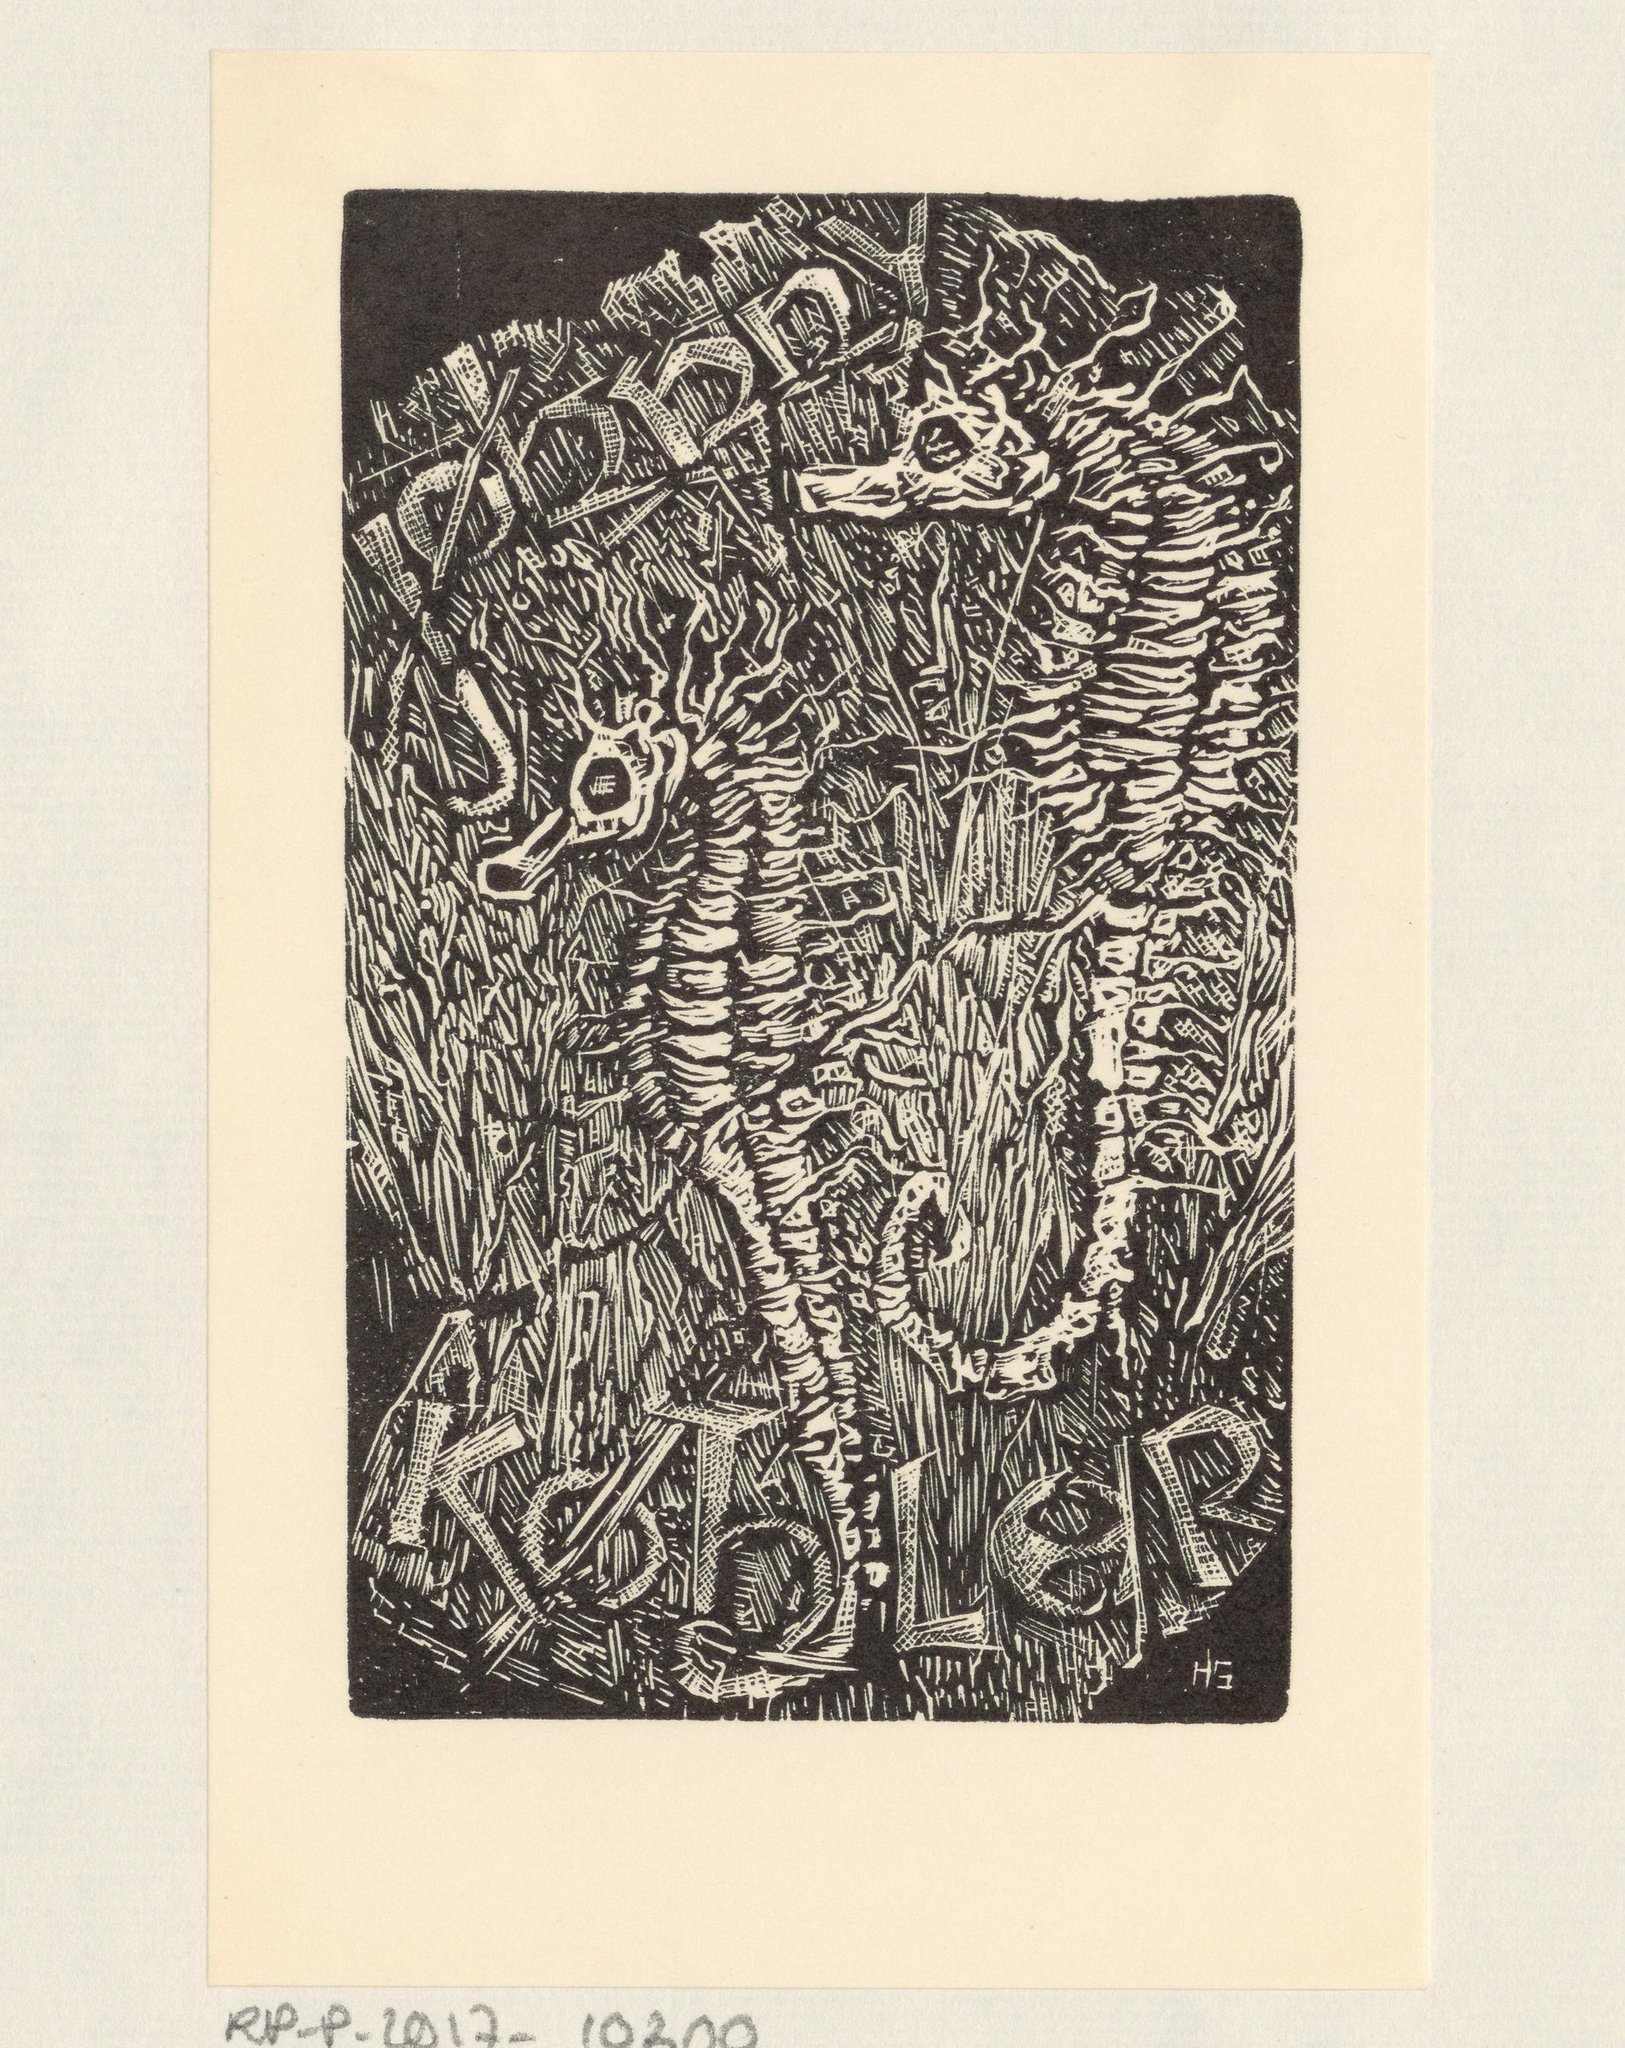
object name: bookplate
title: Ex libris van Johnny Køhler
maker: hans rudolf schulze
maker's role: print maker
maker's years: 1870-1951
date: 1958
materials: paper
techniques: woodcut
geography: leipzig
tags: bony fishes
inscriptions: workshop stamp: ‘Dr. Hans Schulze/ Leipzig - DDR/ woodcut 1958’